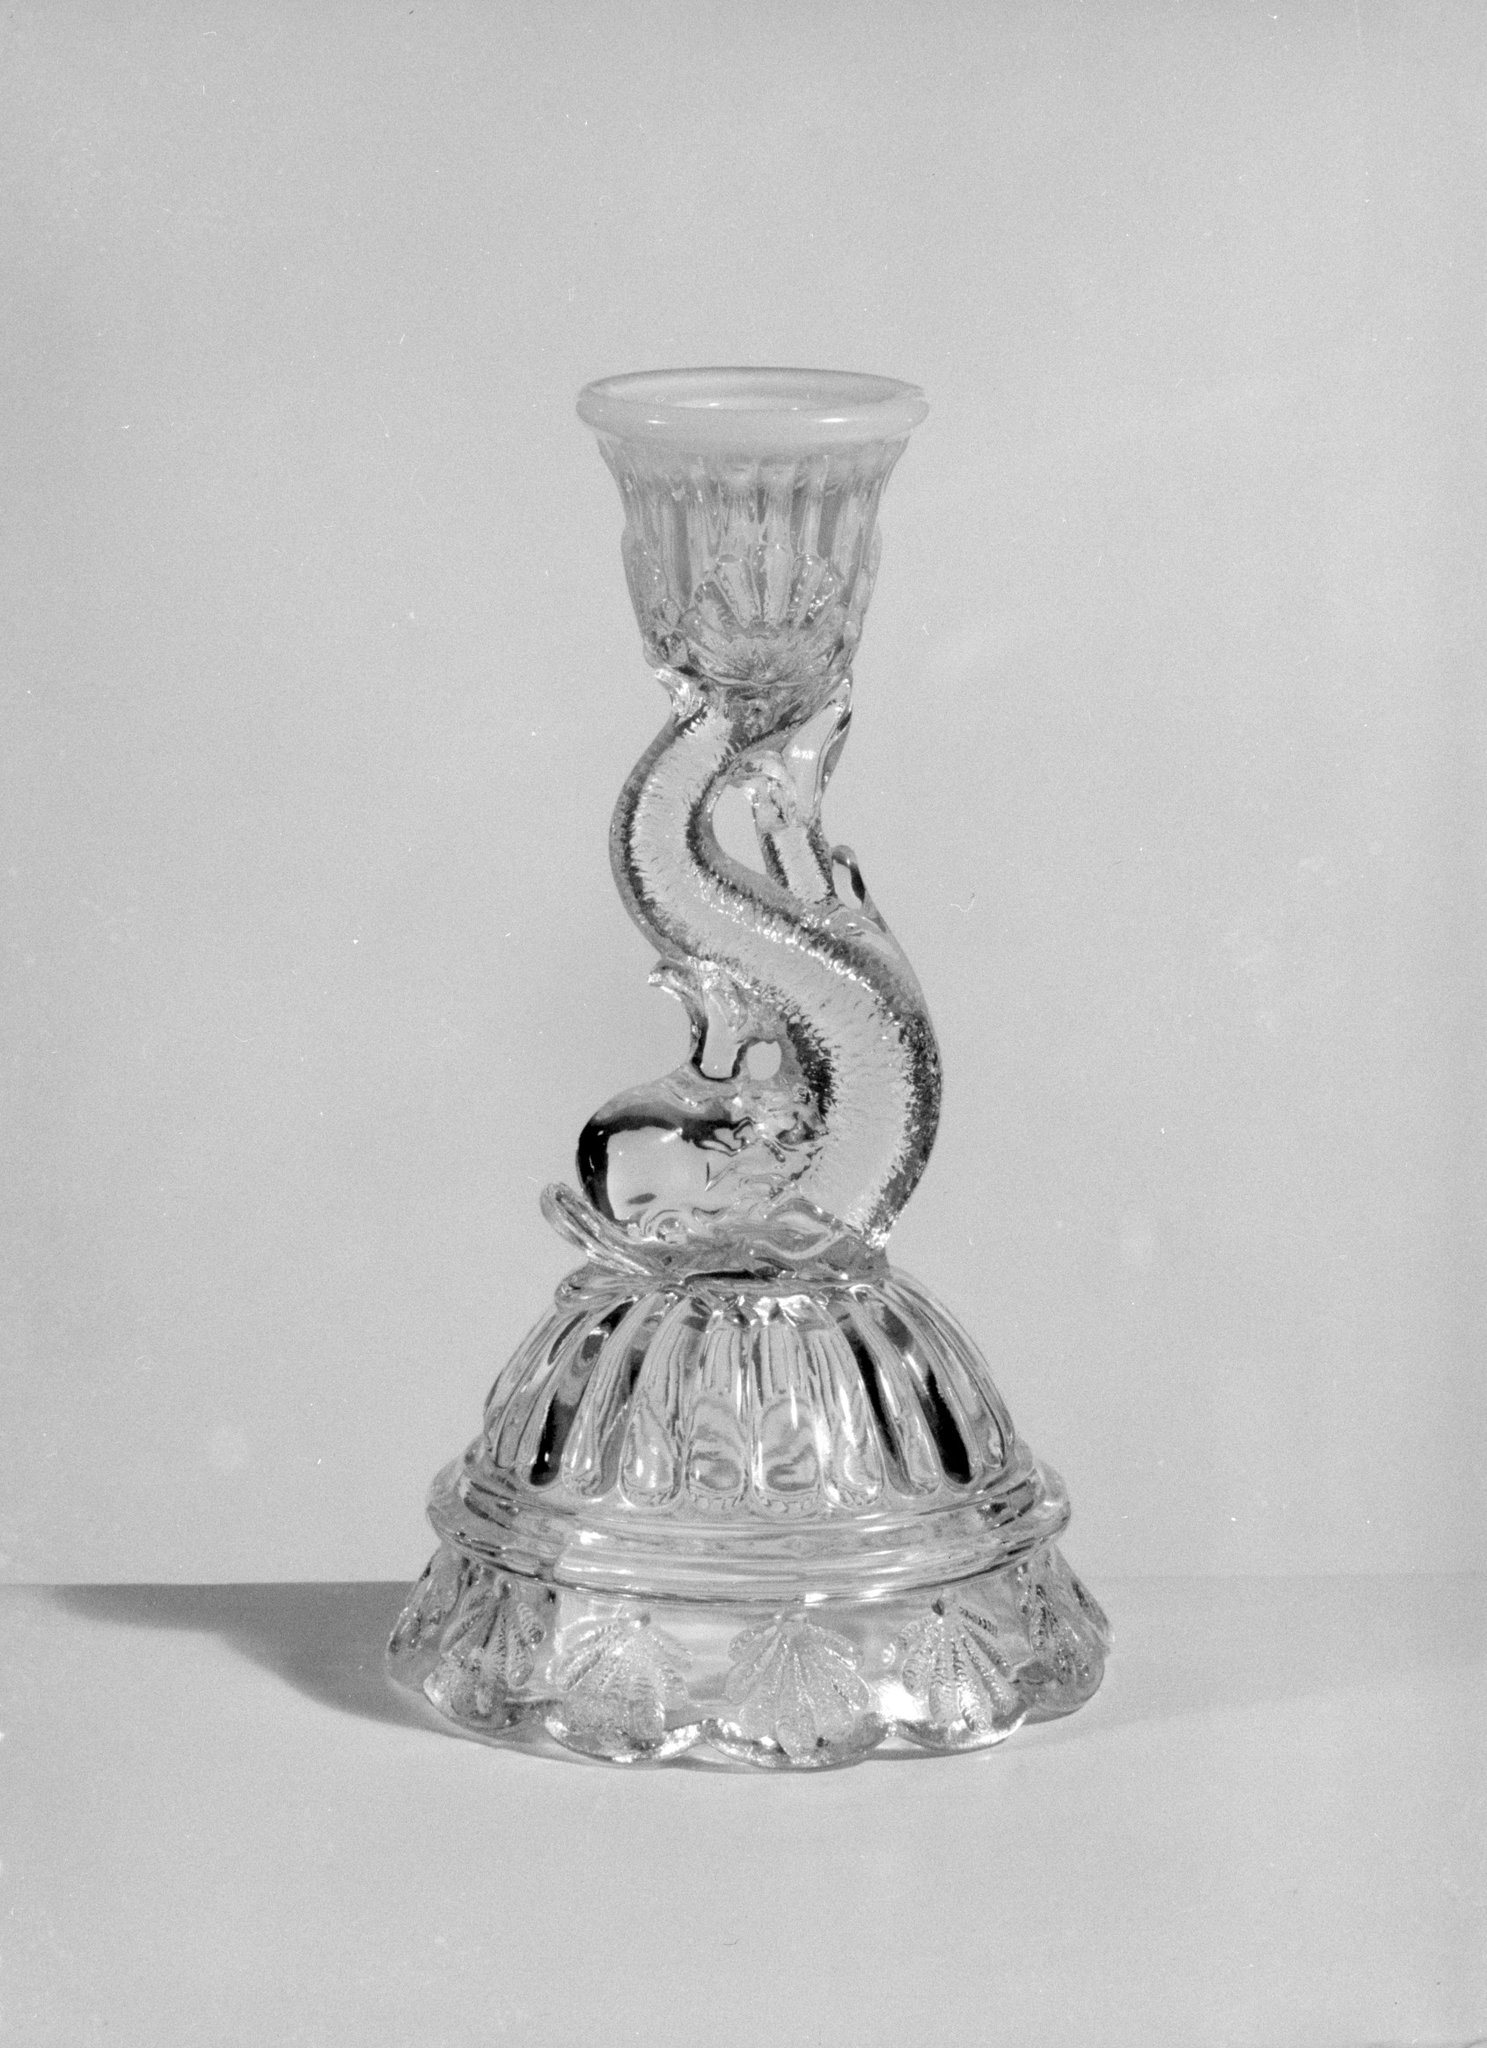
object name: candlestick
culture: american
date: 1875-1900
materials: glass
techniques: pressed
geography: united states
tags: dolphins